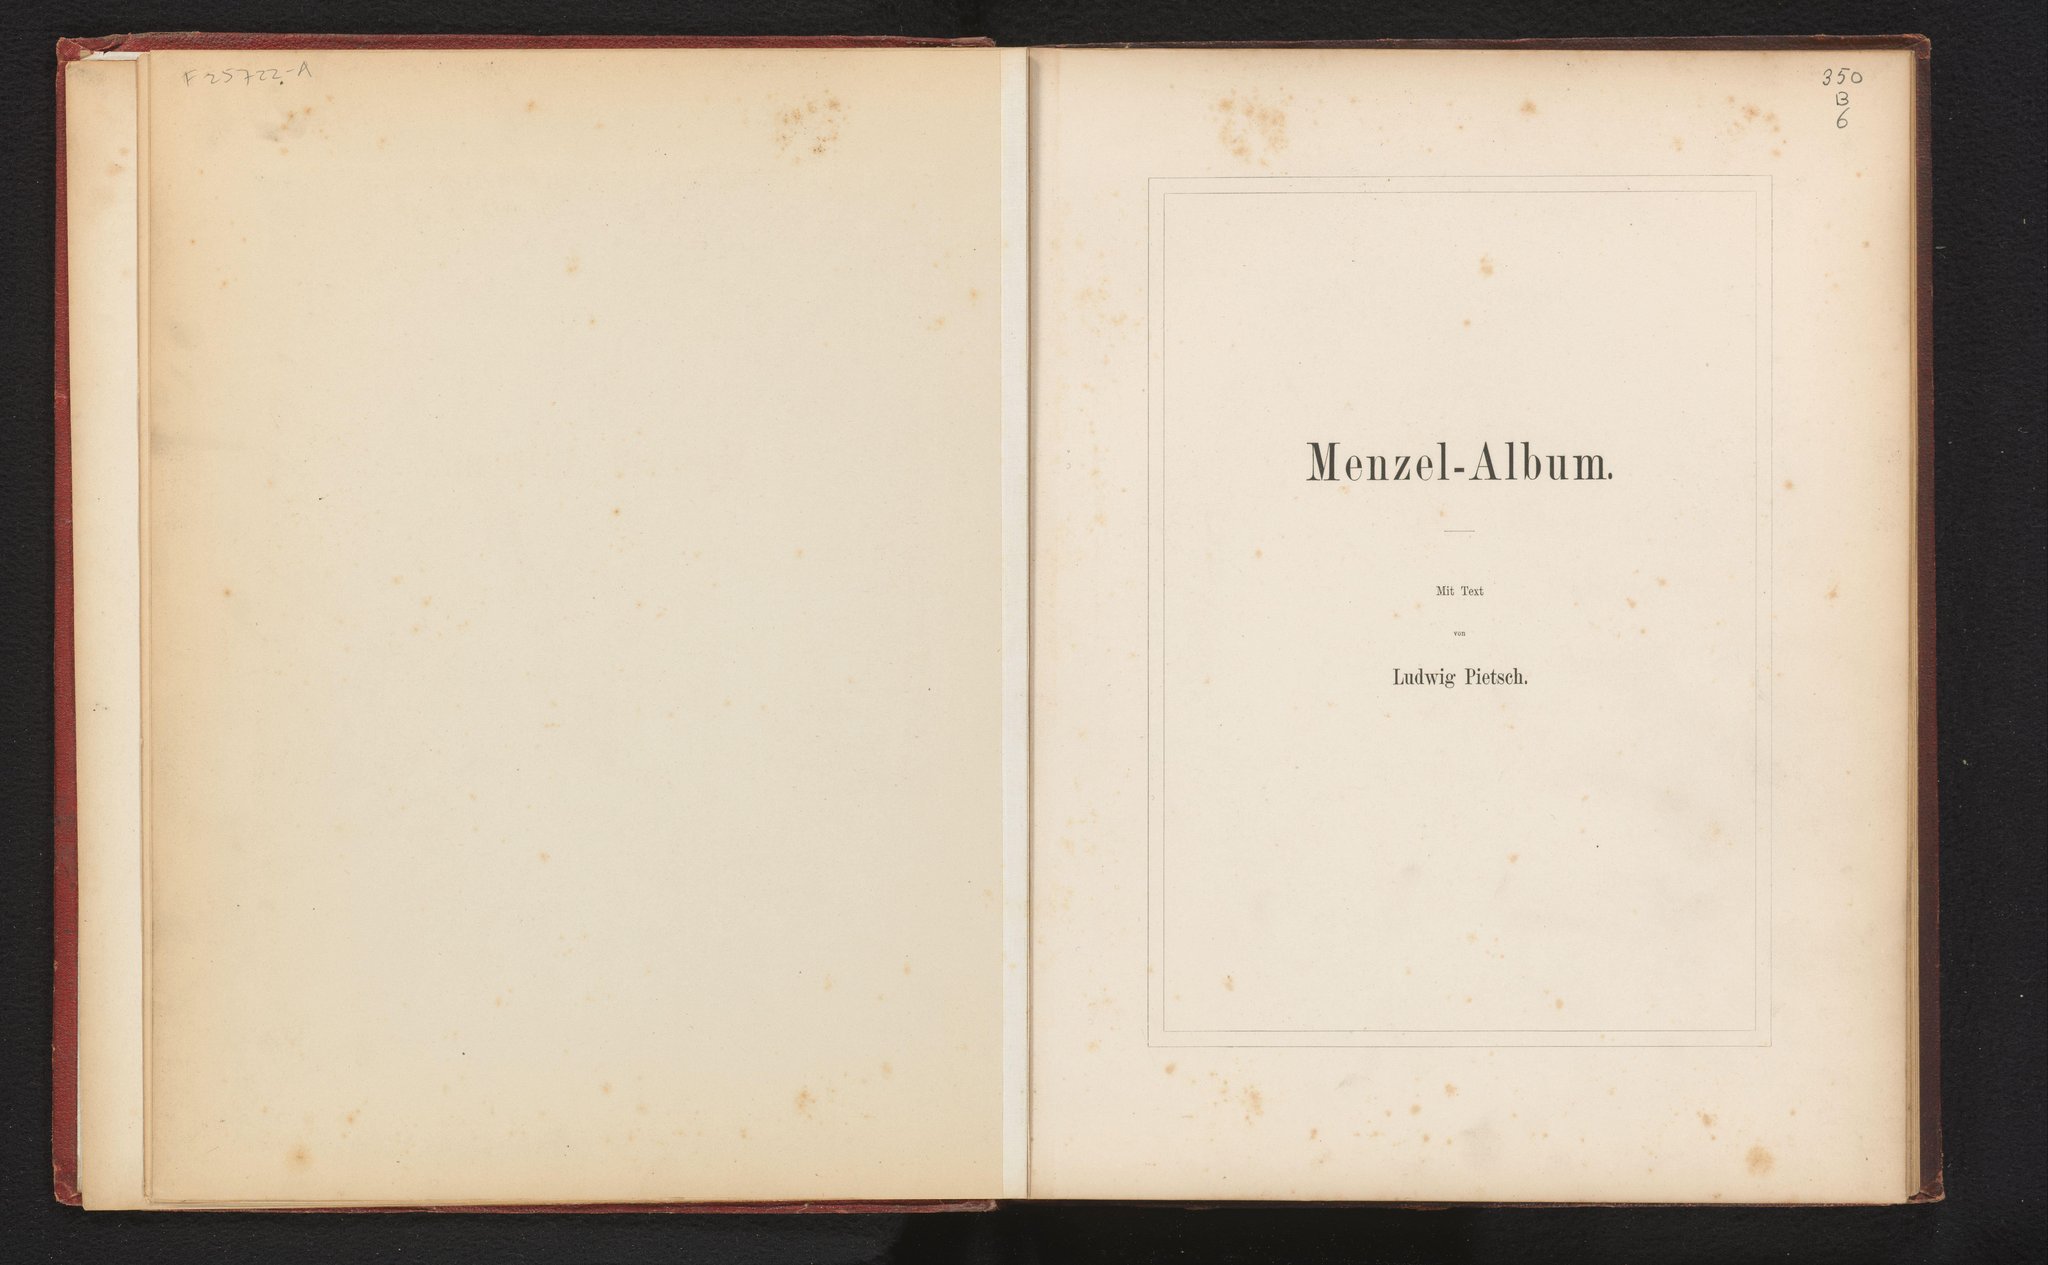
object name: book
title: Menzel-Album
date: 1868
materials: cardboard, paper, textile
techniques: albumen print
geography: berlin